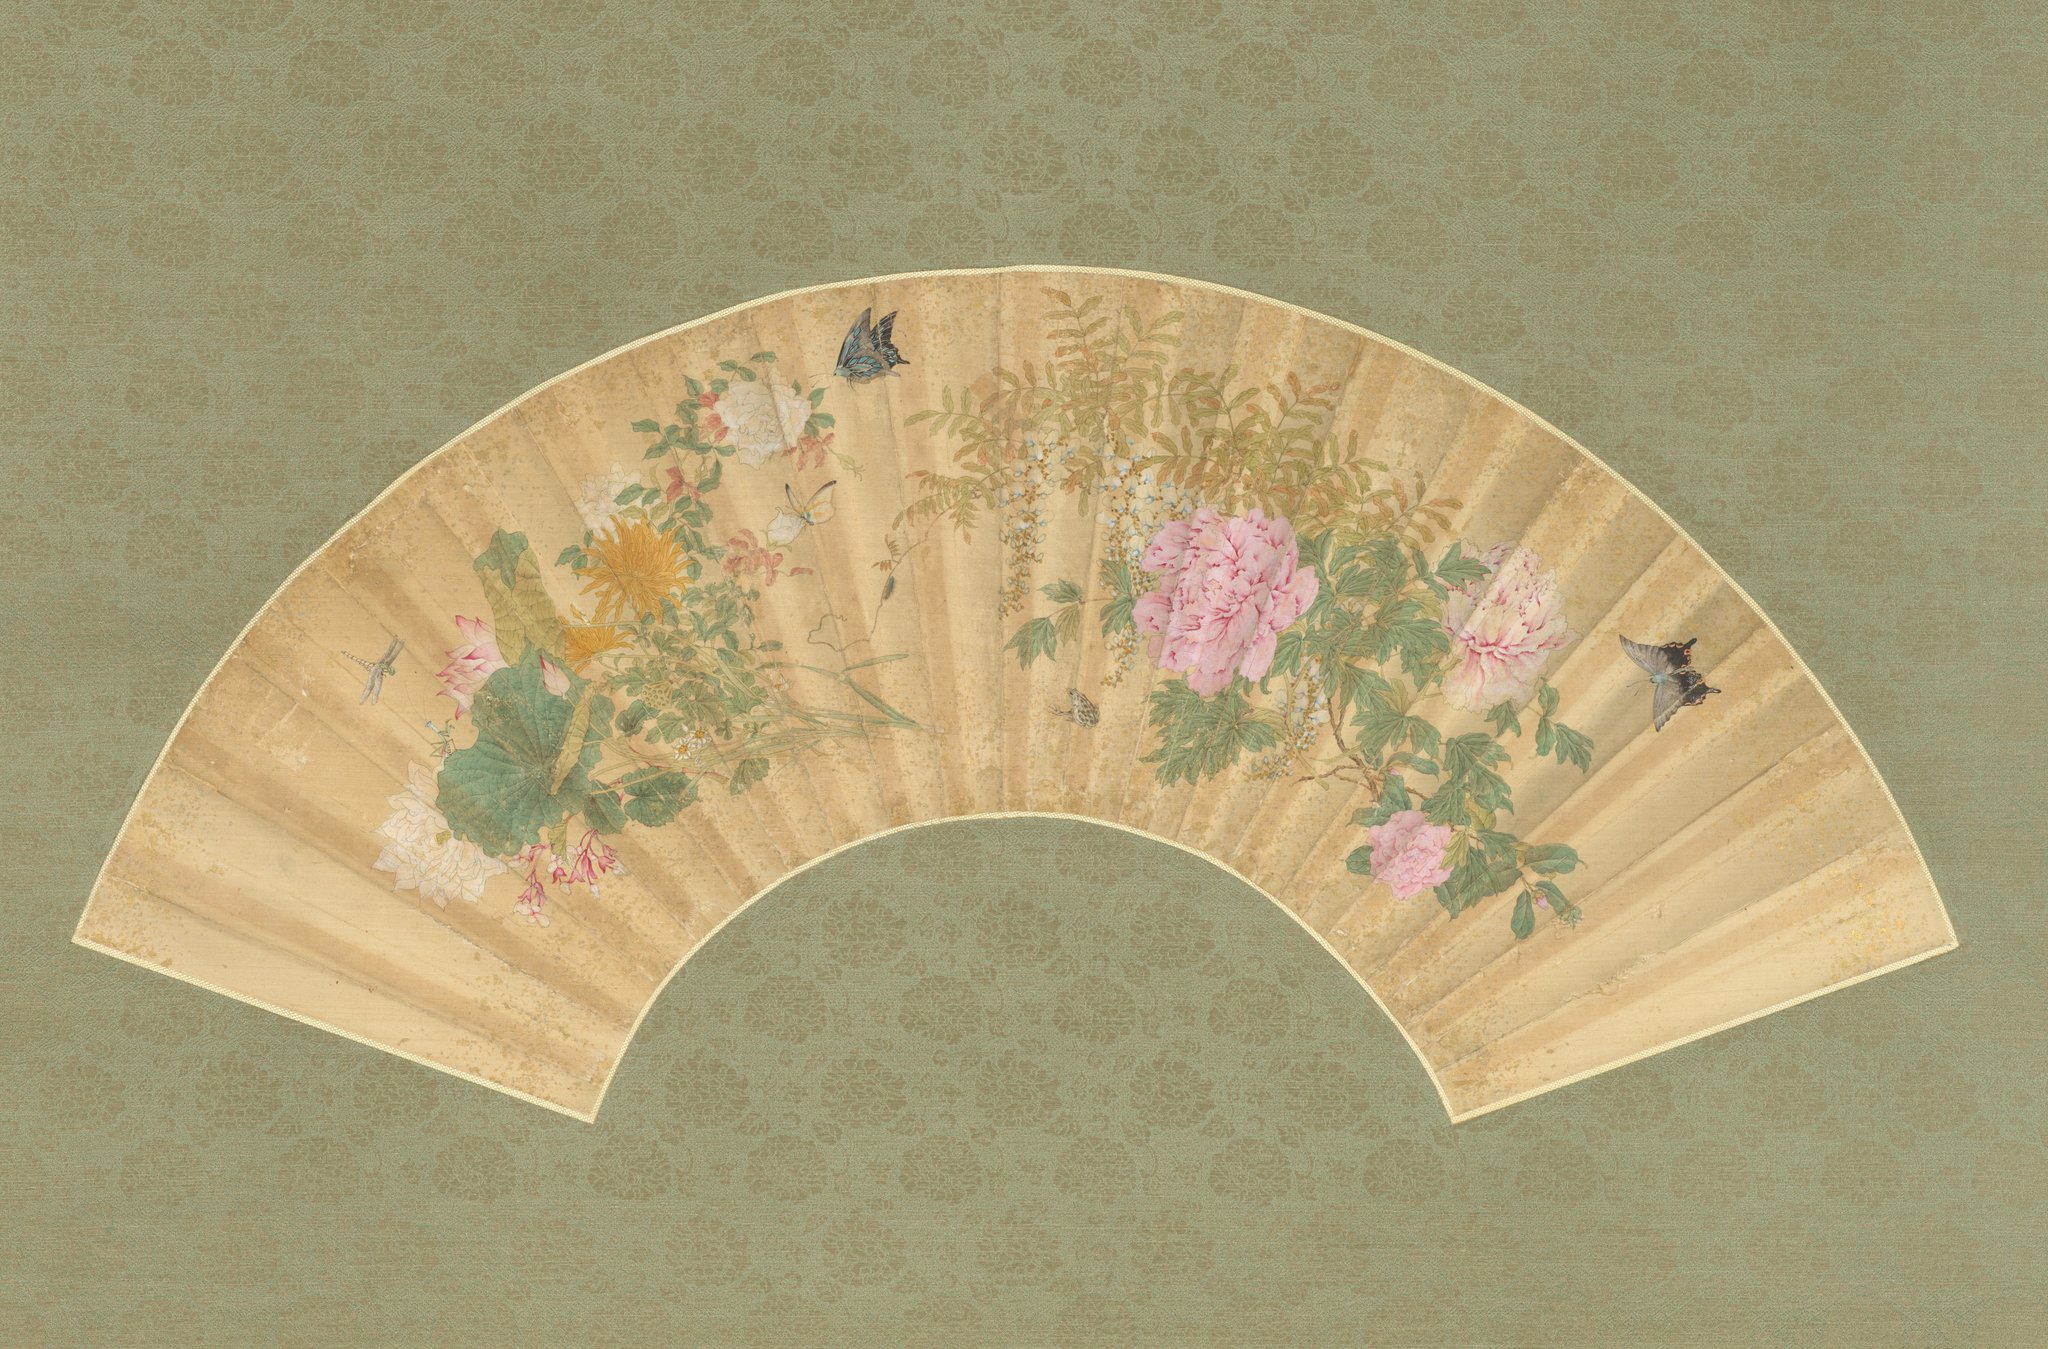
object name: hanging scroll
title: Summer Flowers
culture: japanese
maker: katsushika isai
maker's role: artist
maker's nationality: japanese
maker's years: 1821-1880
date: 1821-1868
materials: ink, silk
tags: butterflies,flowers